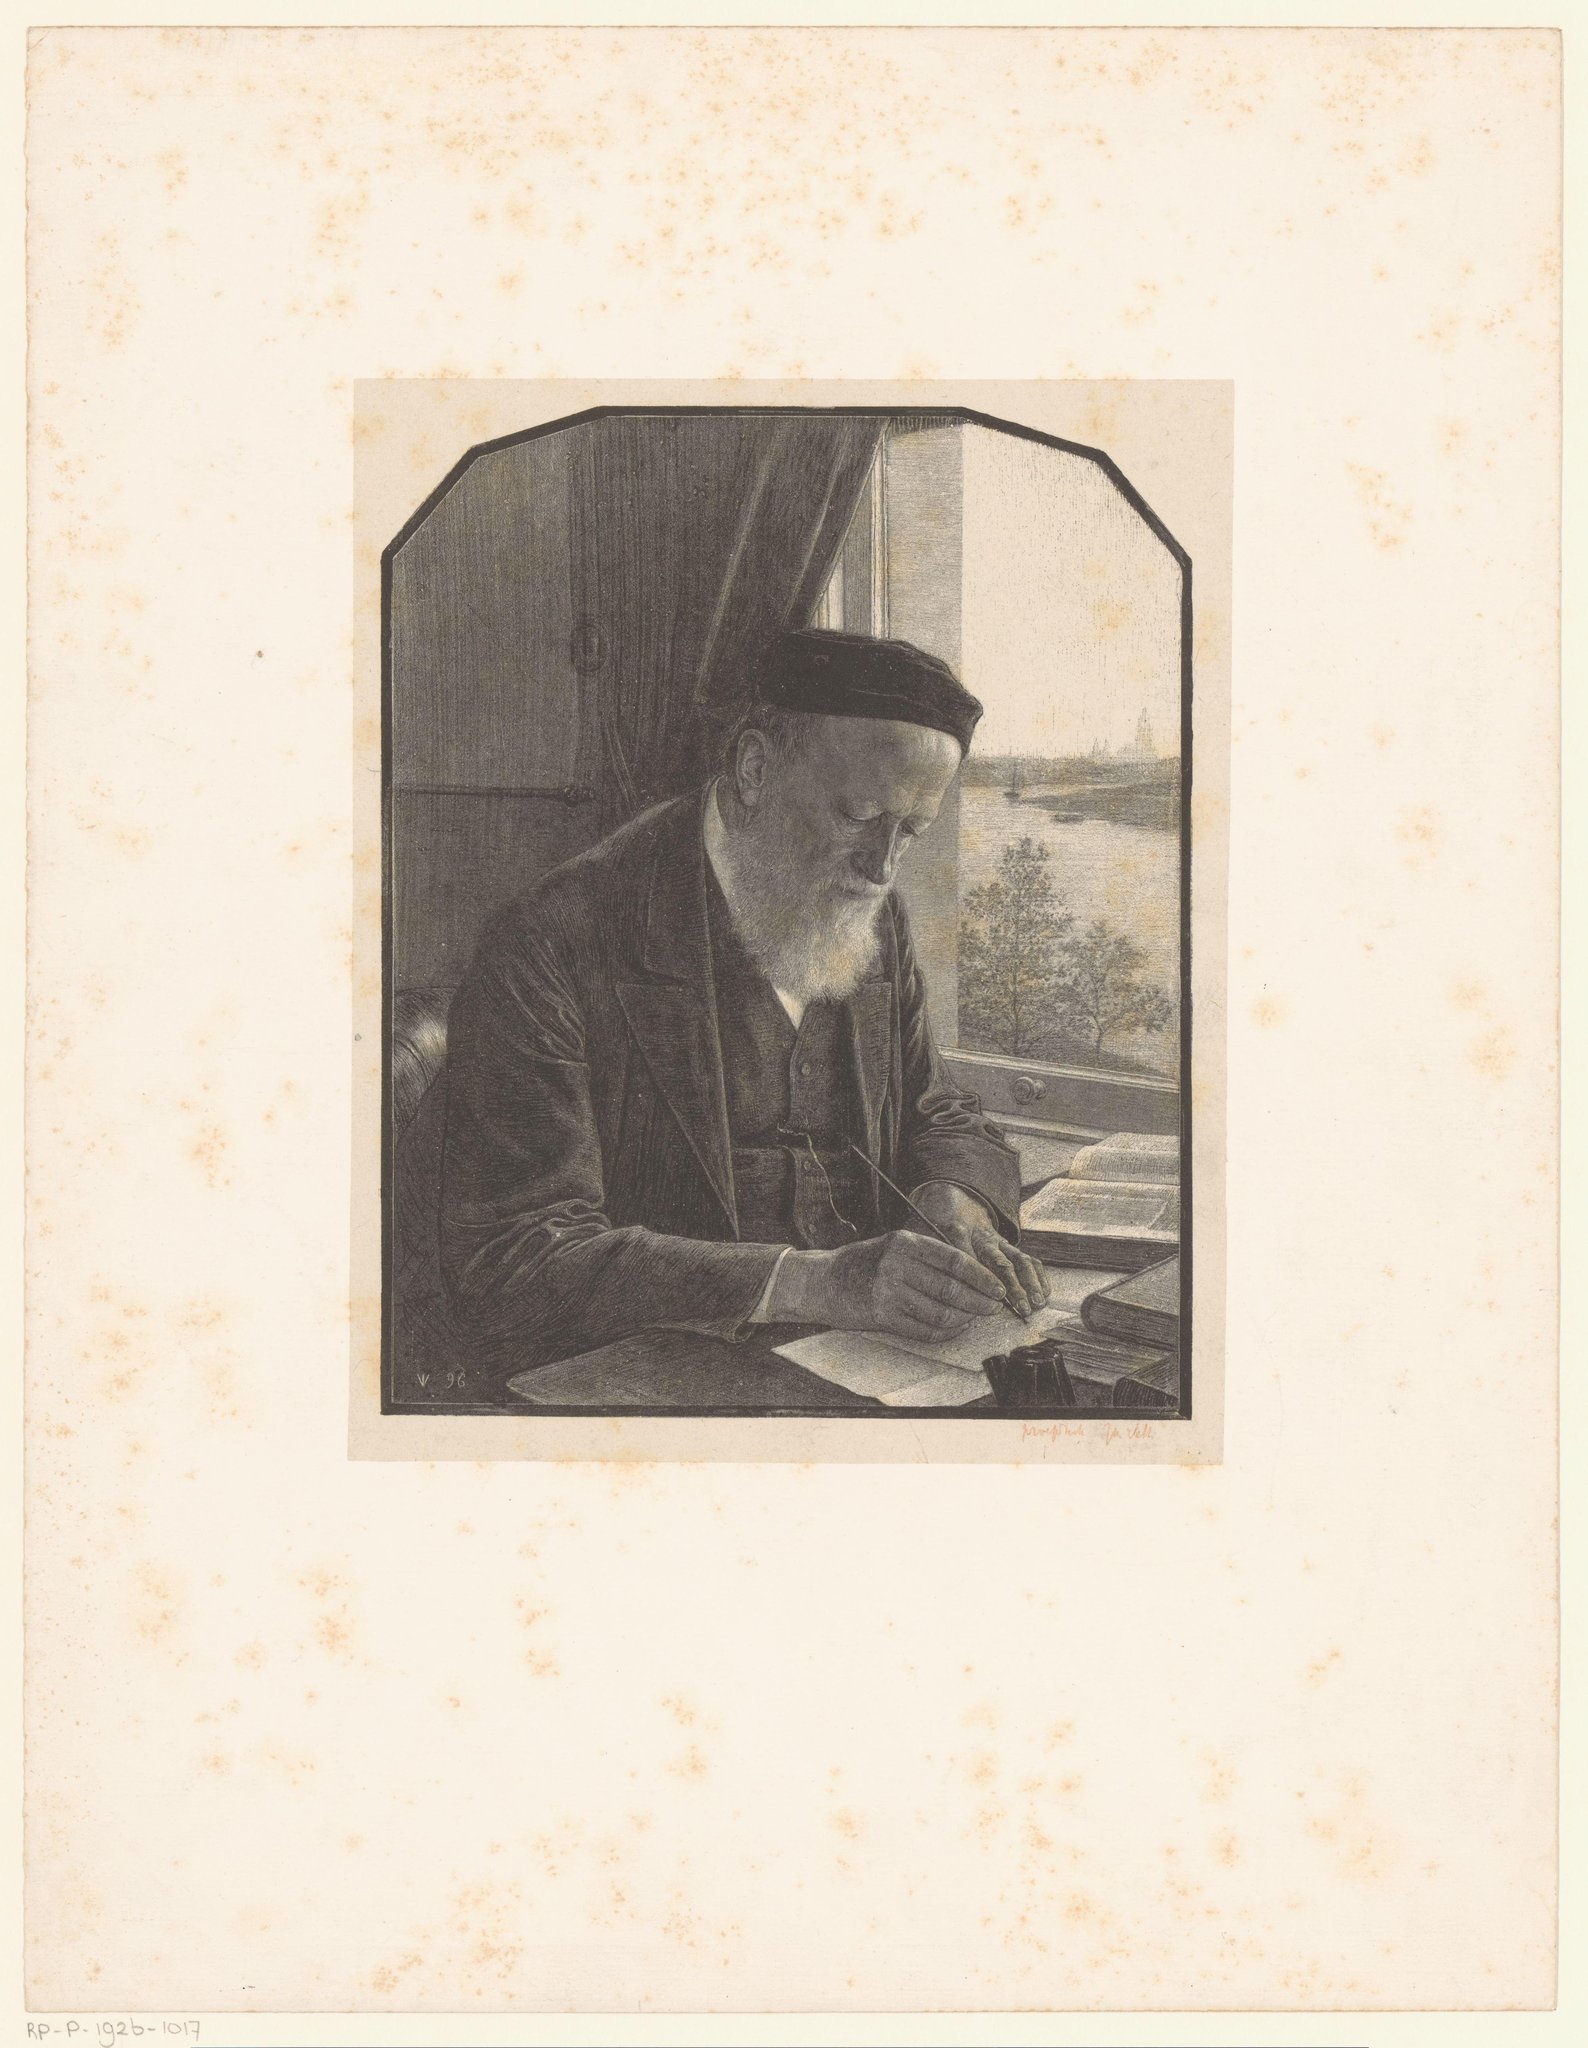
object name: print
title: Portret van Pieter Johannes Veth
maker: jan veth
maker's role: designer, draughtsman, painter, print maker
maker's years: 1864-1925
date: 1896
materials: paper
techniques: lithograph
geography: netherlands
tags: dordrecht, arnhem, historical persons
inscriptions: collector's mark: Lugt 2228, collector's mark: ‘H.G. Samson Amsterdam’, inscription: ‘proefdruk Jan Veth’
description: De geportretteerde zit schrijvend aan een tafel met rechts uitzicht op de Rijn bij Arnhem.